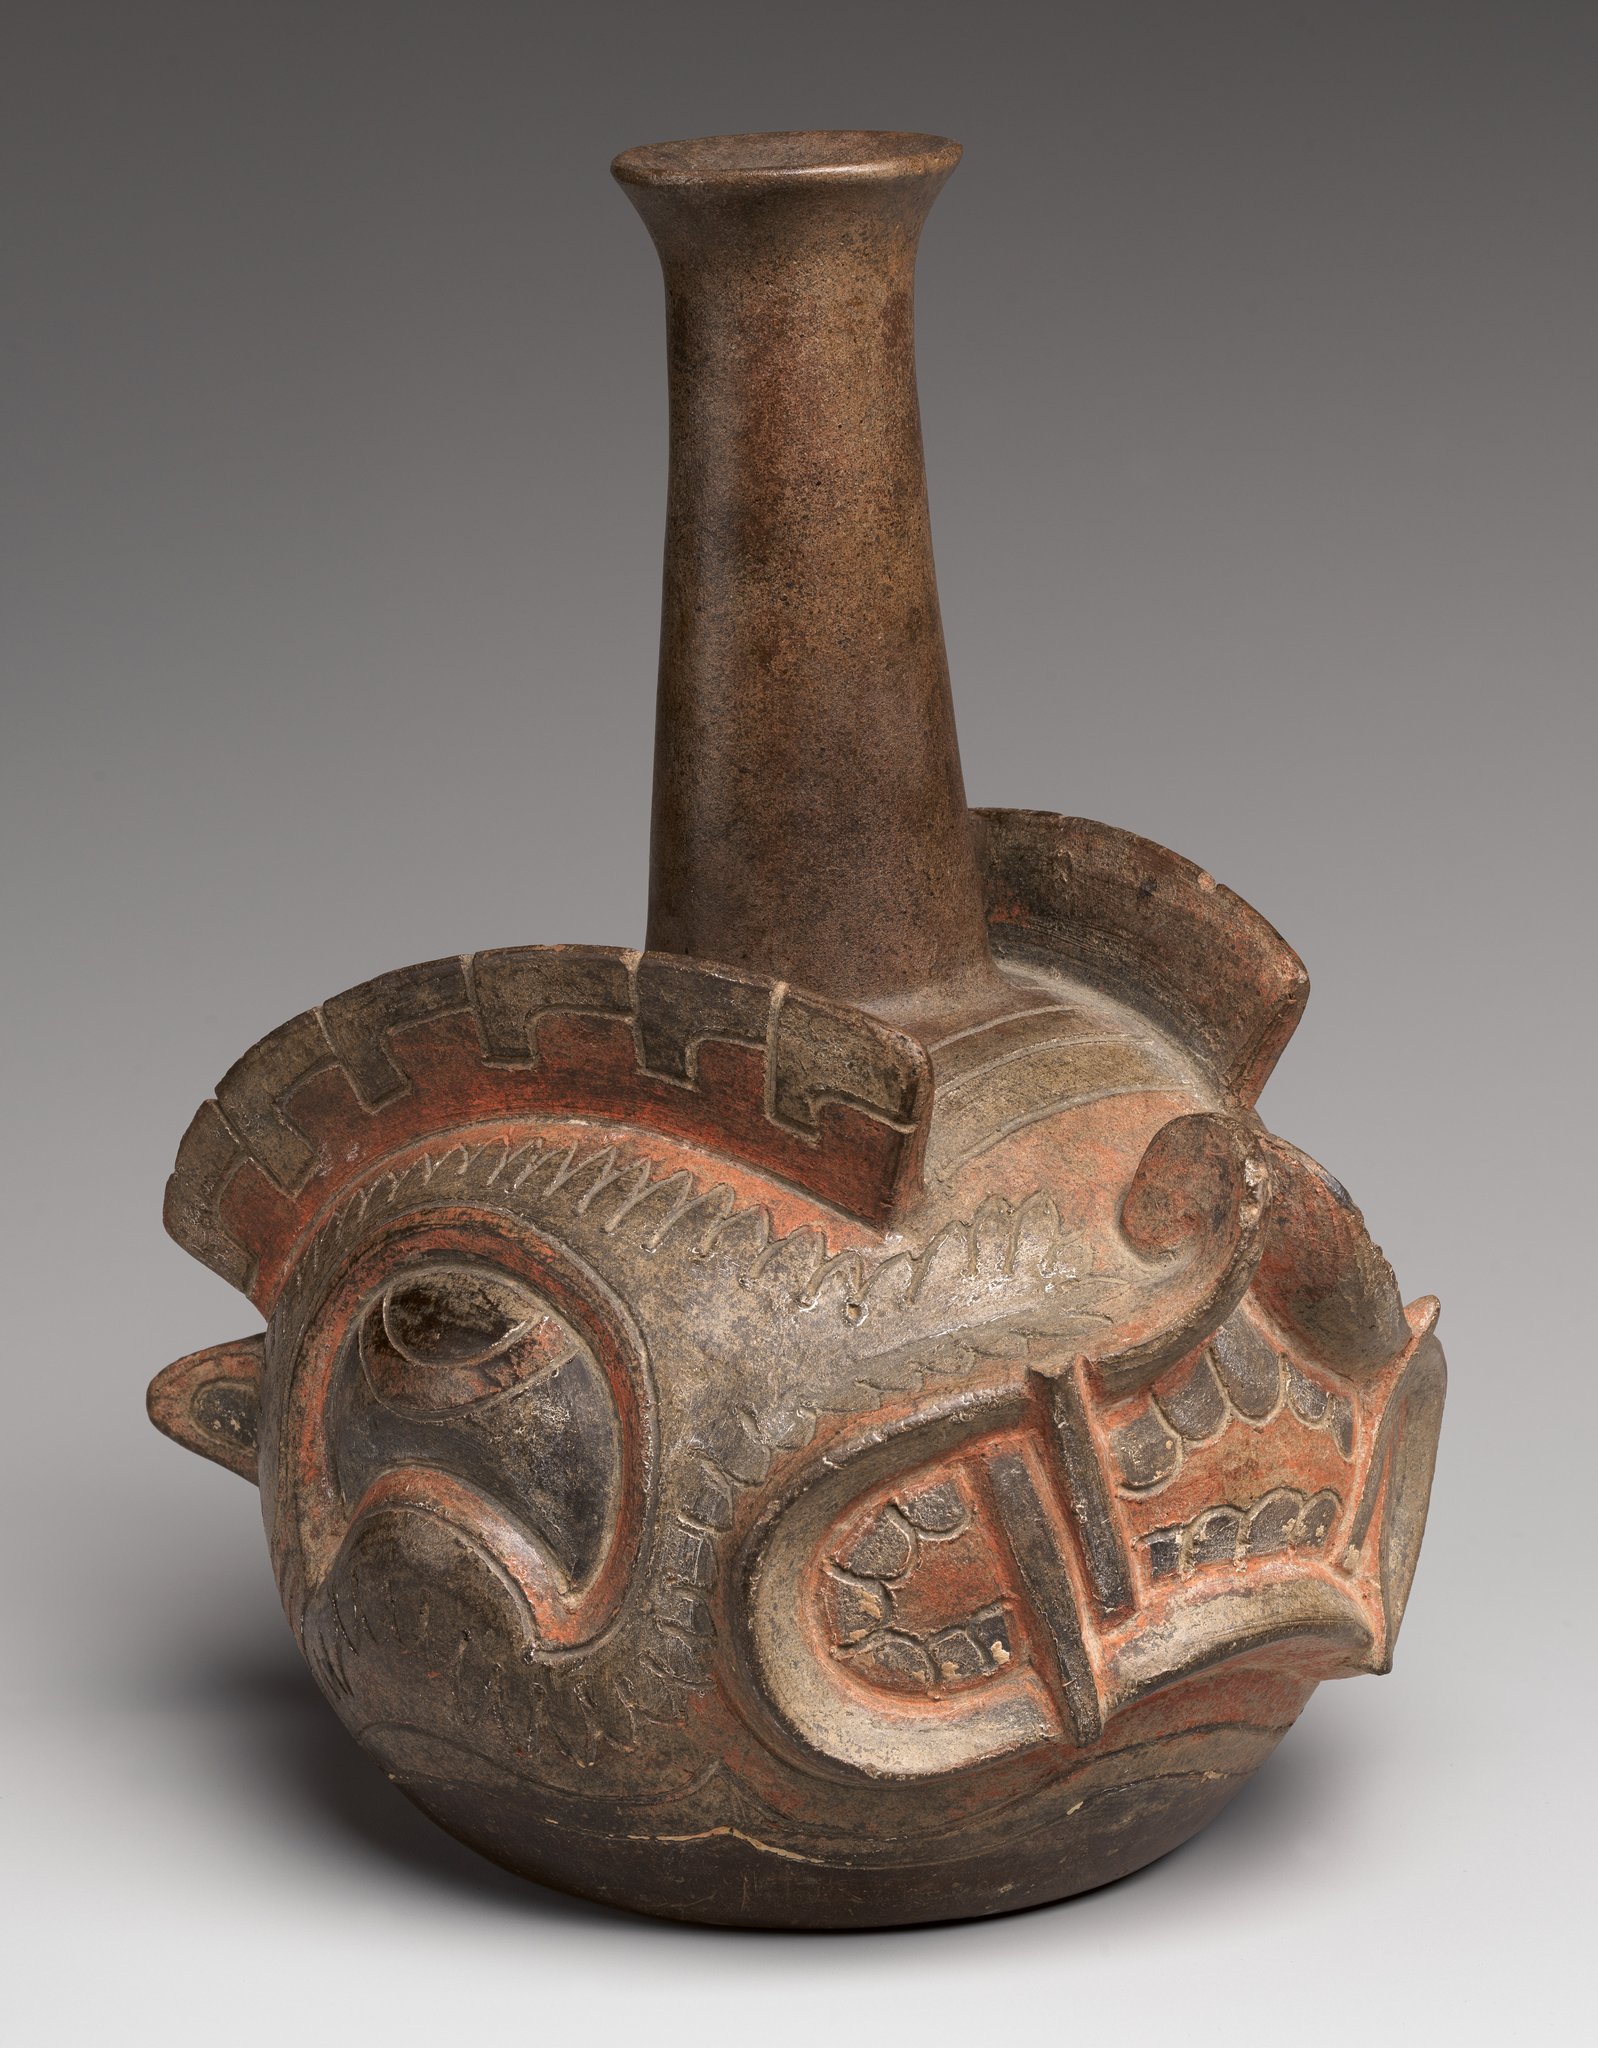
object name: bottle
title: Bottle with leaf-nosed bat head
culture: cupisnique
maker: cupisnique artist(s)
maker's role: artist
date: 1200-800 BCE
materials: ceramic, paint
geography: peru